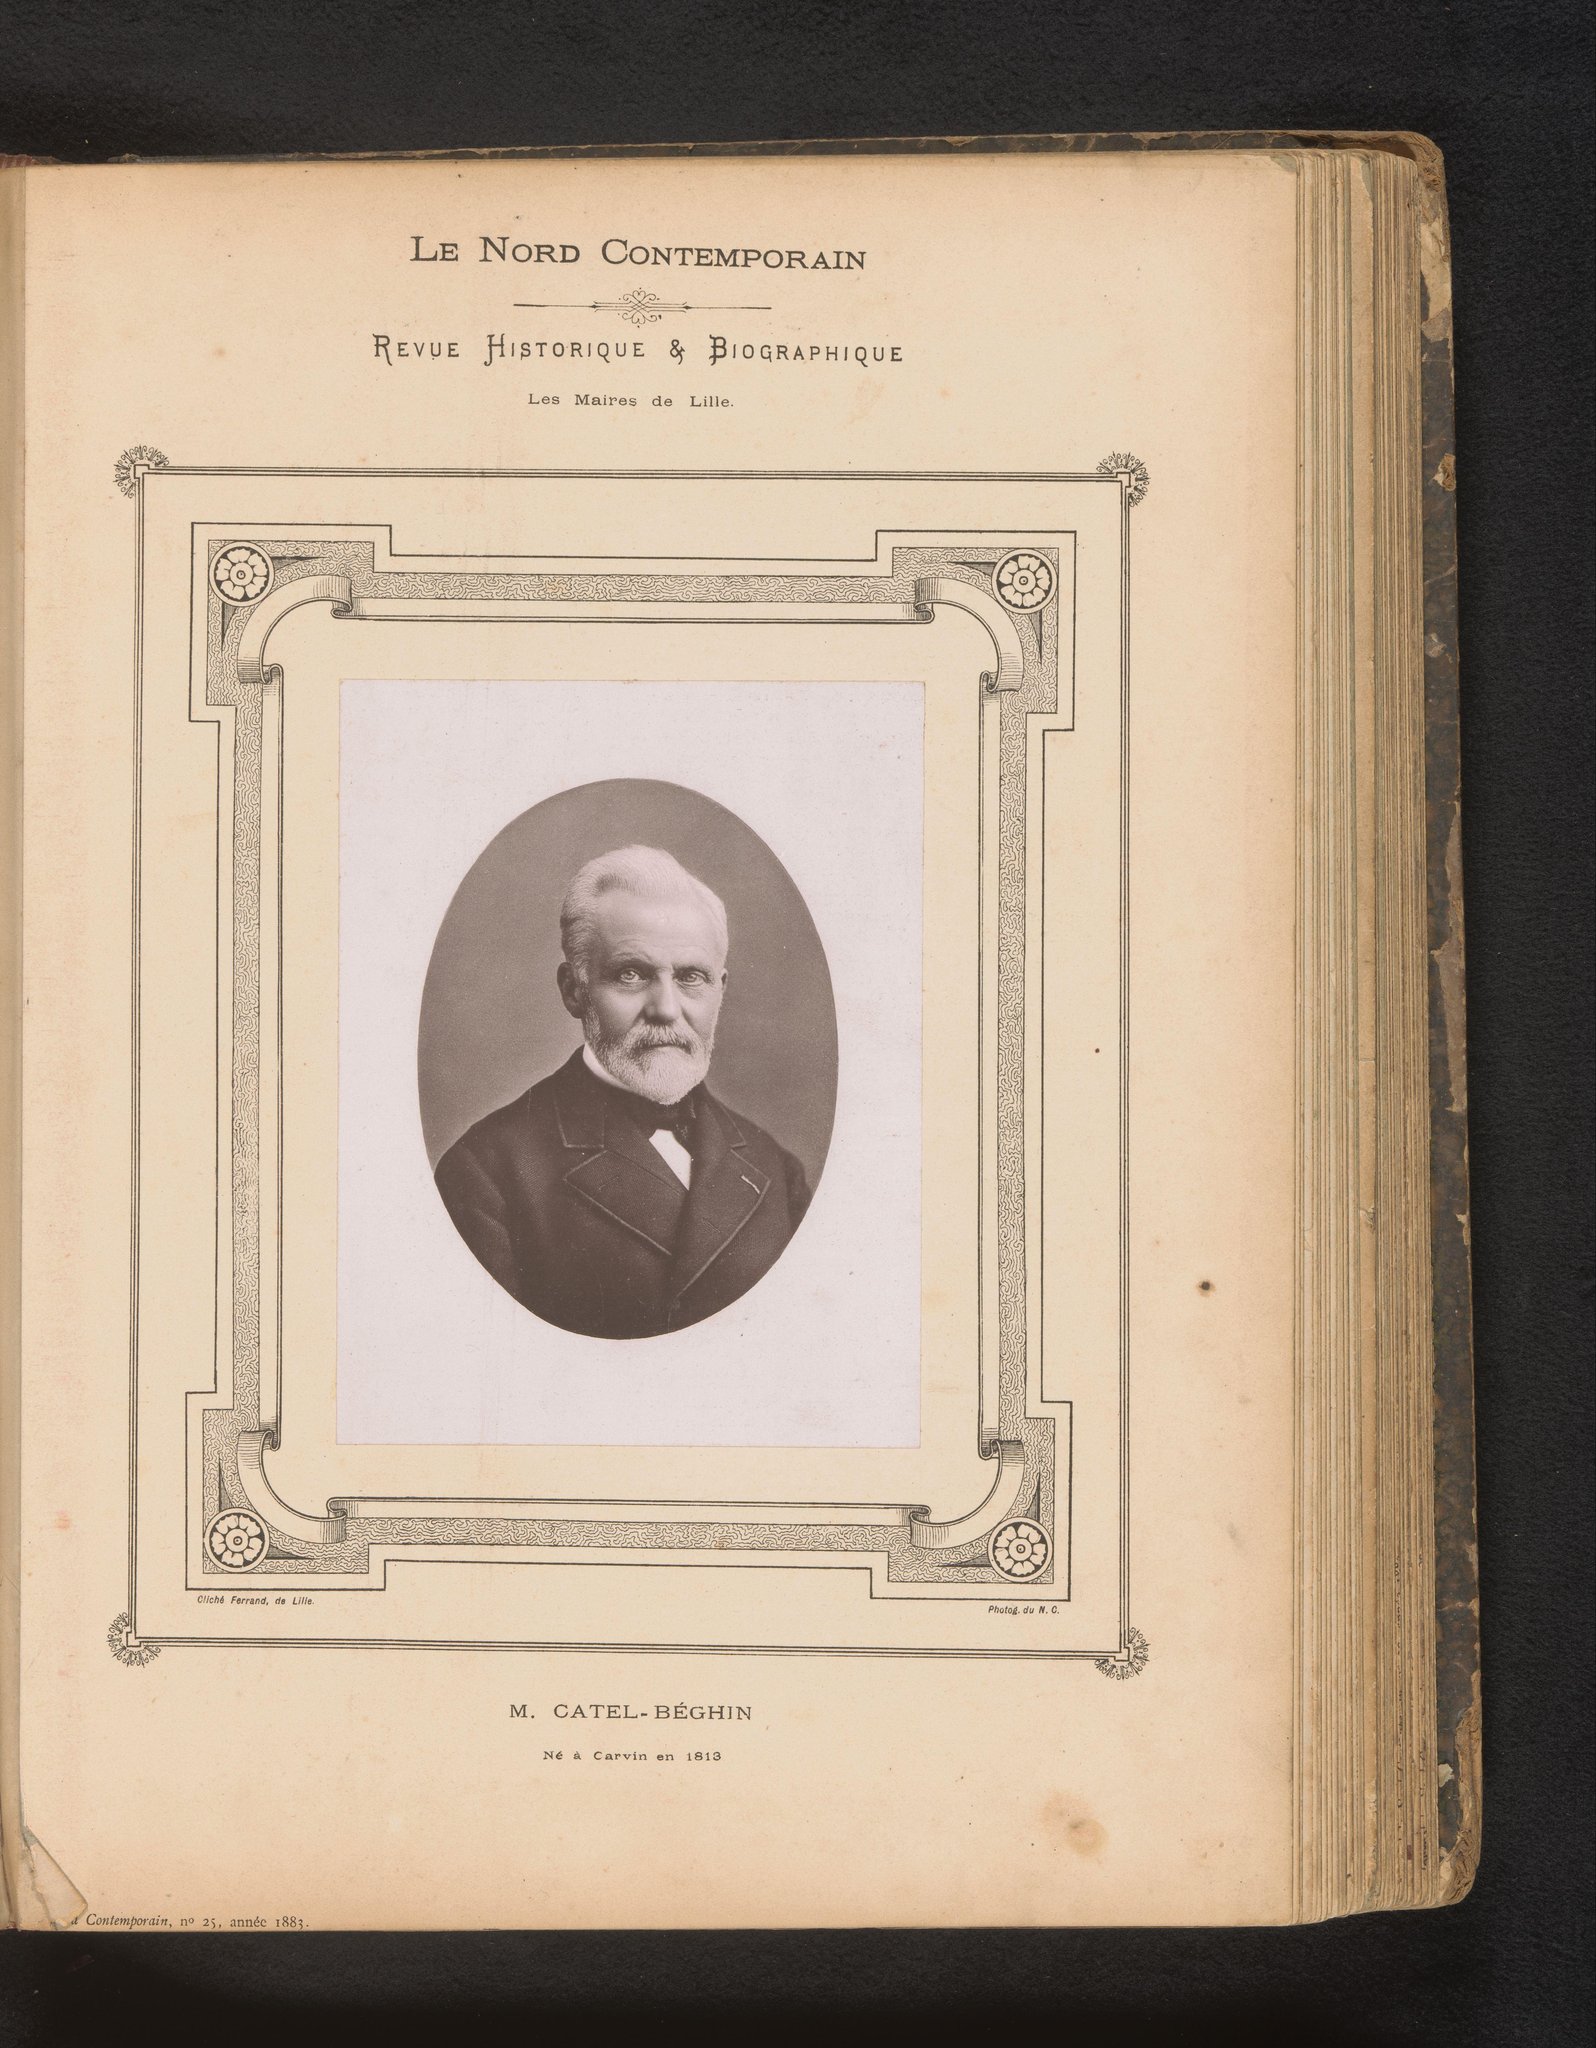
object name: page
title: M. Catel-Béghin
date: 1878-1883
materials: paper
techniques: photograph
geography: lille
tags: politician, mayor, historical persons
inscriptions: inscription: ‘[Journal le Nord] Contemporain, No 25, année 1883.’, inscription: ‘Né à Carvin en 1813’, inscription: ‘Le Nord Contemporain/ Revue Historique & Biographique/ Les Maires de Lille.’